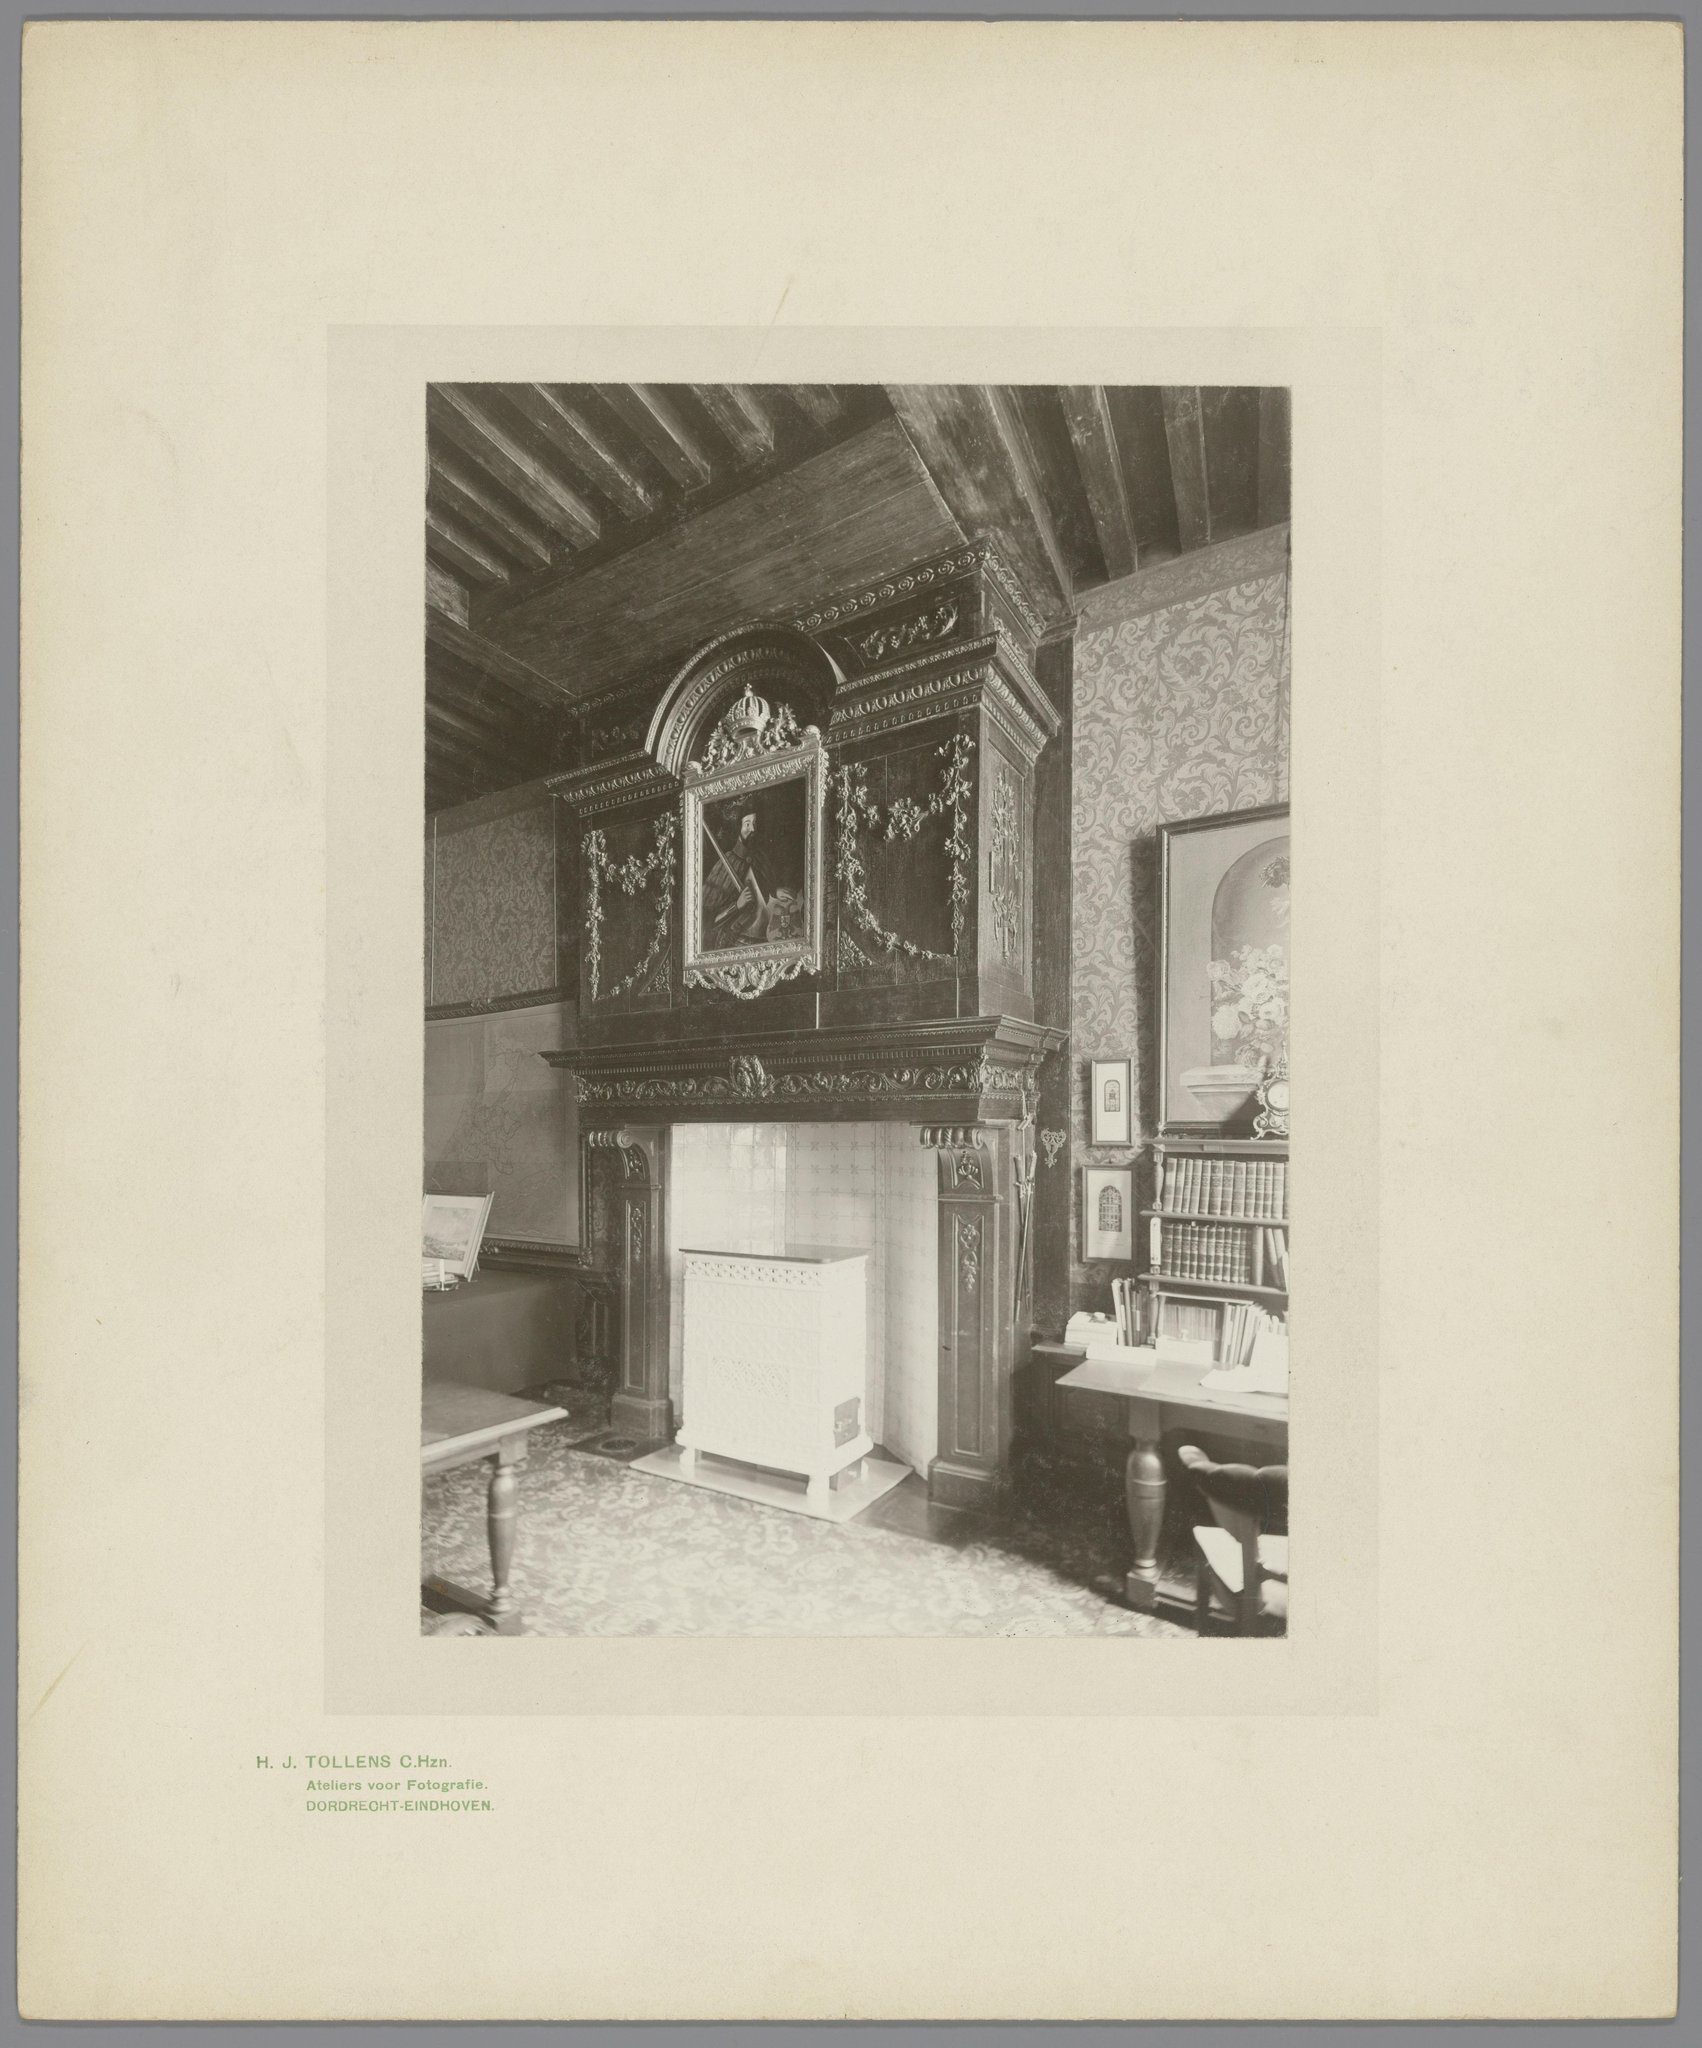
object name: photograph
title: Interieur van een kamer in het Rijnlandshuis te Leiden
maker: henricus jacobus tollens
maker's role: painter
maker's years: 1864-1936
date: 1880-1910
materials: cardboard, photographic support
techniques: collodion silver print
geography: leiden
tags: interior of the house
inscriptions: annotation: ‘Rijnlandshuis Leiden/ No.1’, inscription: ‘113’, inscription: ‘H.J. Tollens C. Hzn./ Ateliers voor Fotografie/ Dordrecht-Eindhoven’